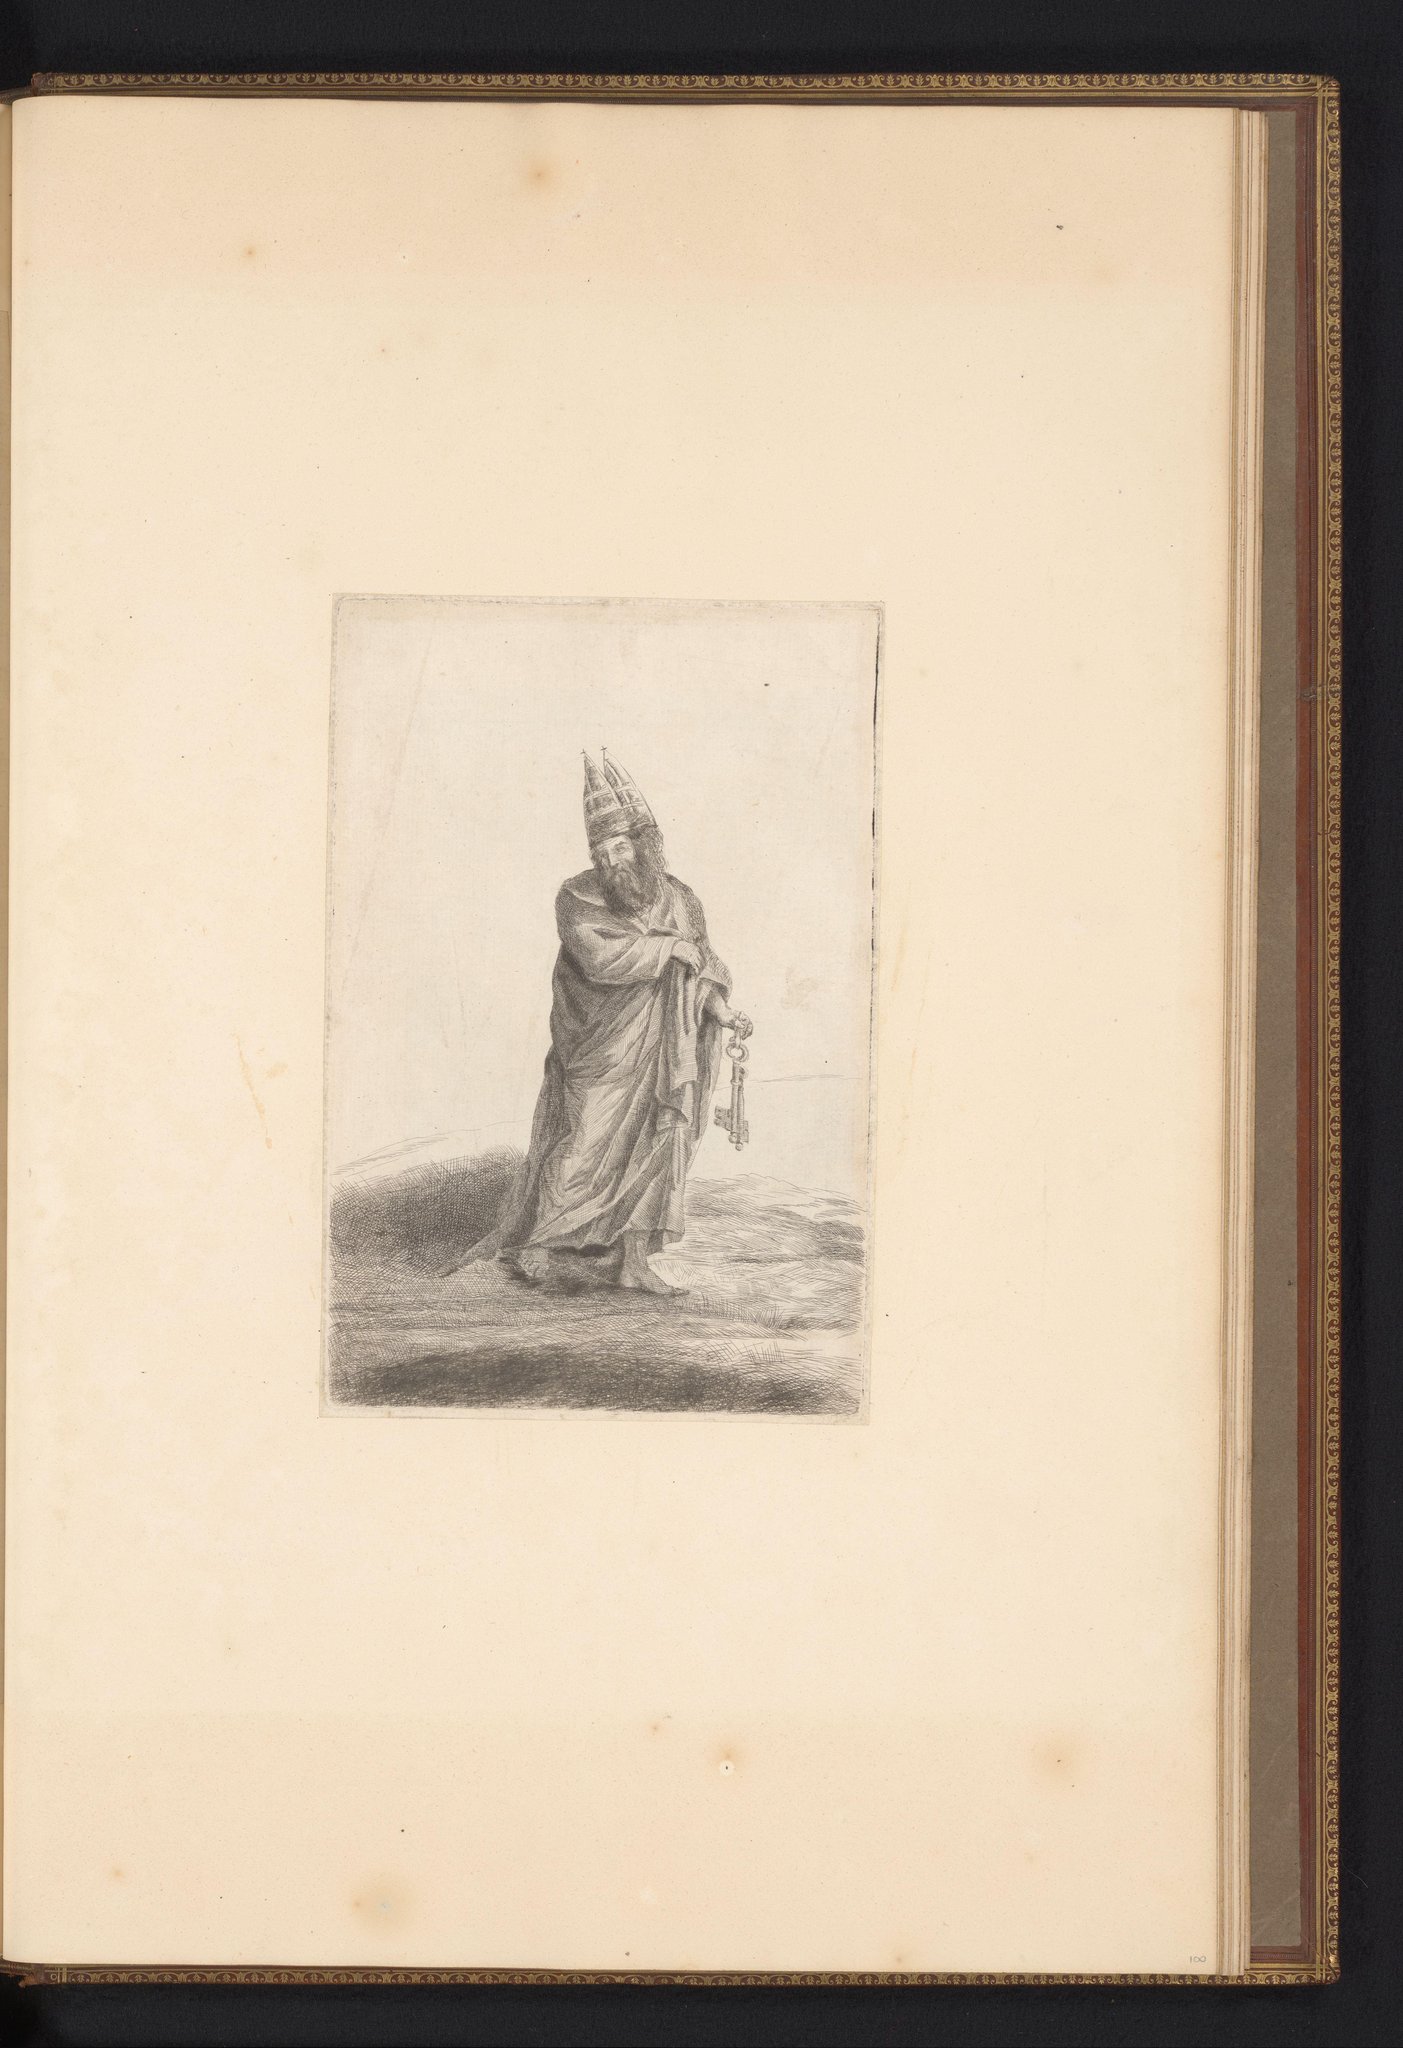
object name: album leaf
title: Apostel Petrus met tiara en sleutels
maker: william baillie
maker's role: print maker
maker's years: 1723-1810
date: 1753-1810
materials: paper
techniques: drypoint, etching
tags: the apostle peter, first bishop of rome; possible attributes: book, cock, (upturned) cross, (triple) crozier, fish, key, scroll, ship, tiara